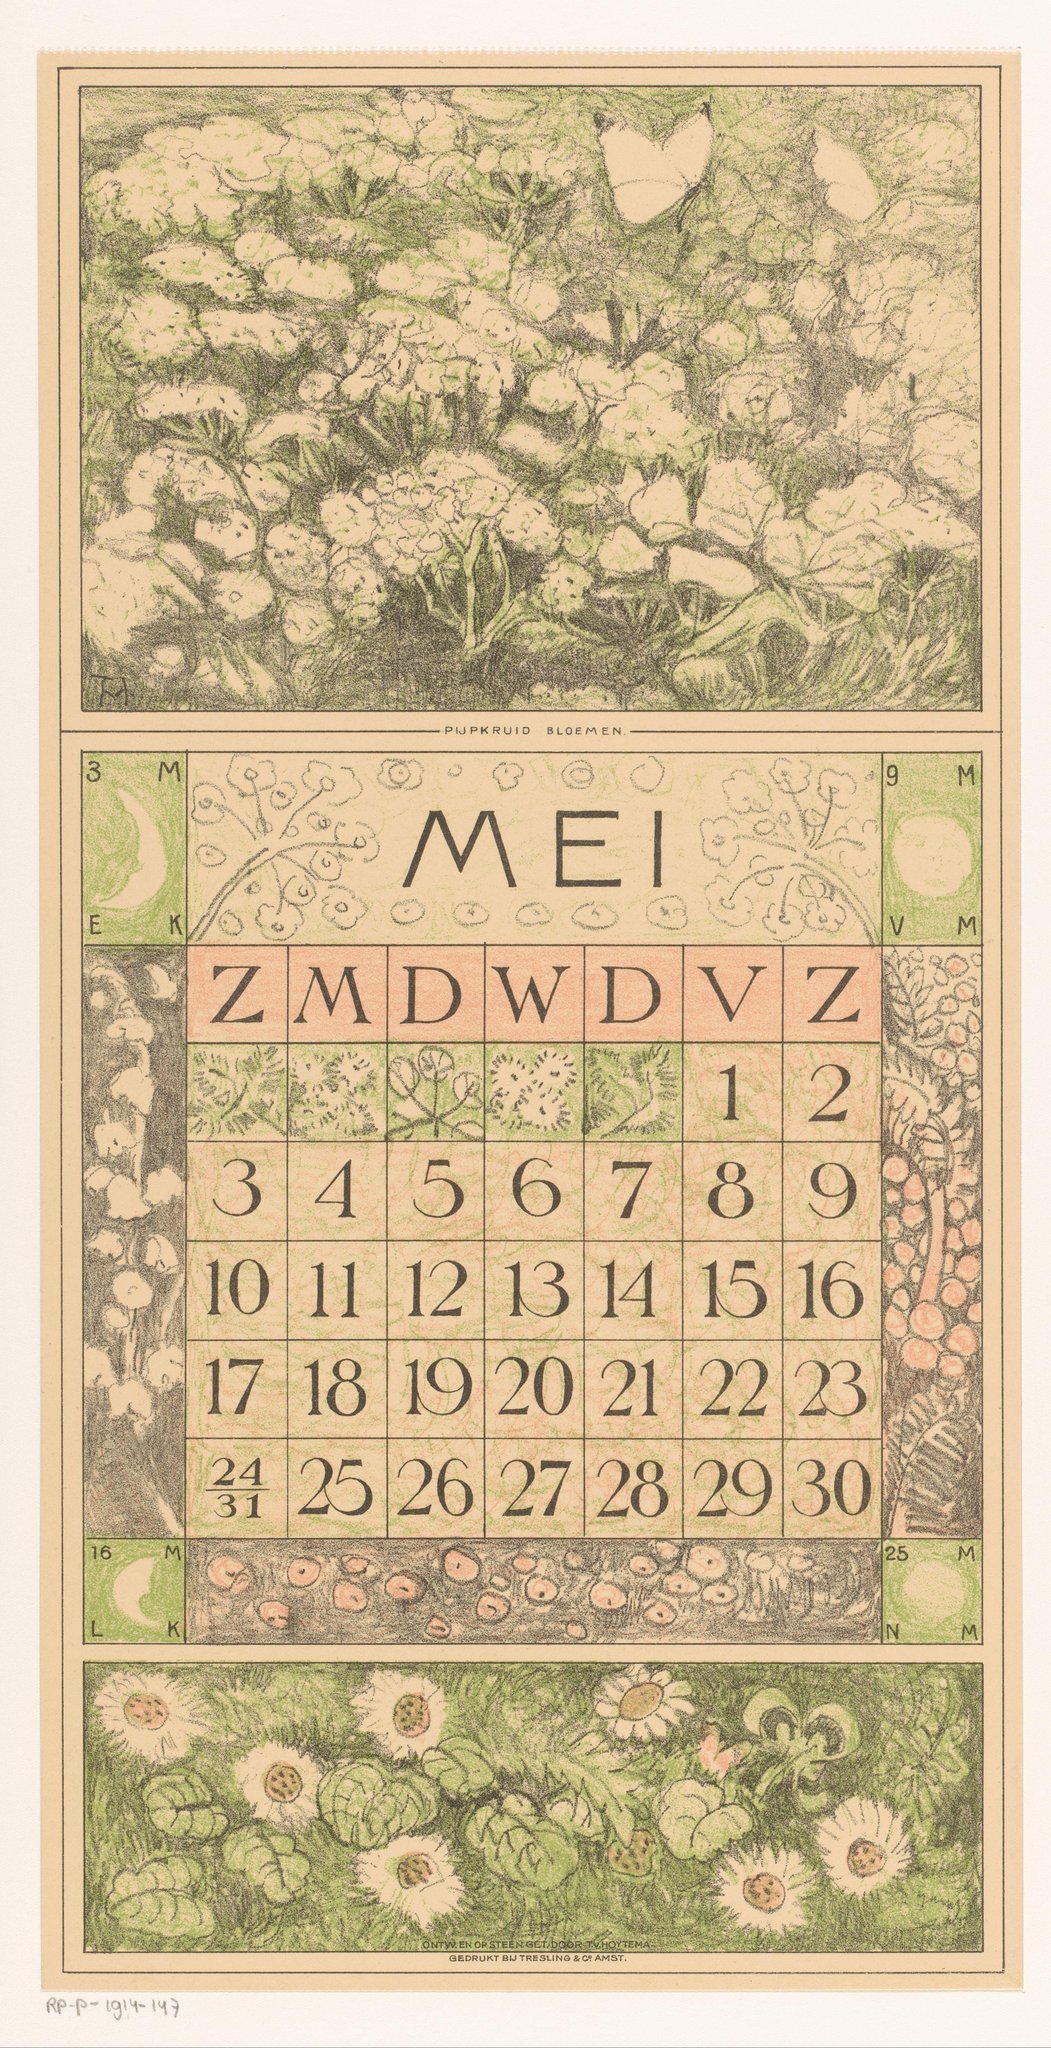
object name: calendar leaf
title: Pijpkruid bloemen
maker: theo van hoytema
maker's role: draughtsman, painter, print maker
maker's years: 1863-1917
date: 1913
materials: paper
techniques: lithograph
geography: the hague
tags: lunar year, plants and herbs: hemlock, may ~ other concepts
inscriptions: collector's mark: Lugt 2228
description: In de ornamentrand en onderin bloemen. In de hoeken de standen van de maan op vier dagen. Bovenaan het blad een scheurlijn.